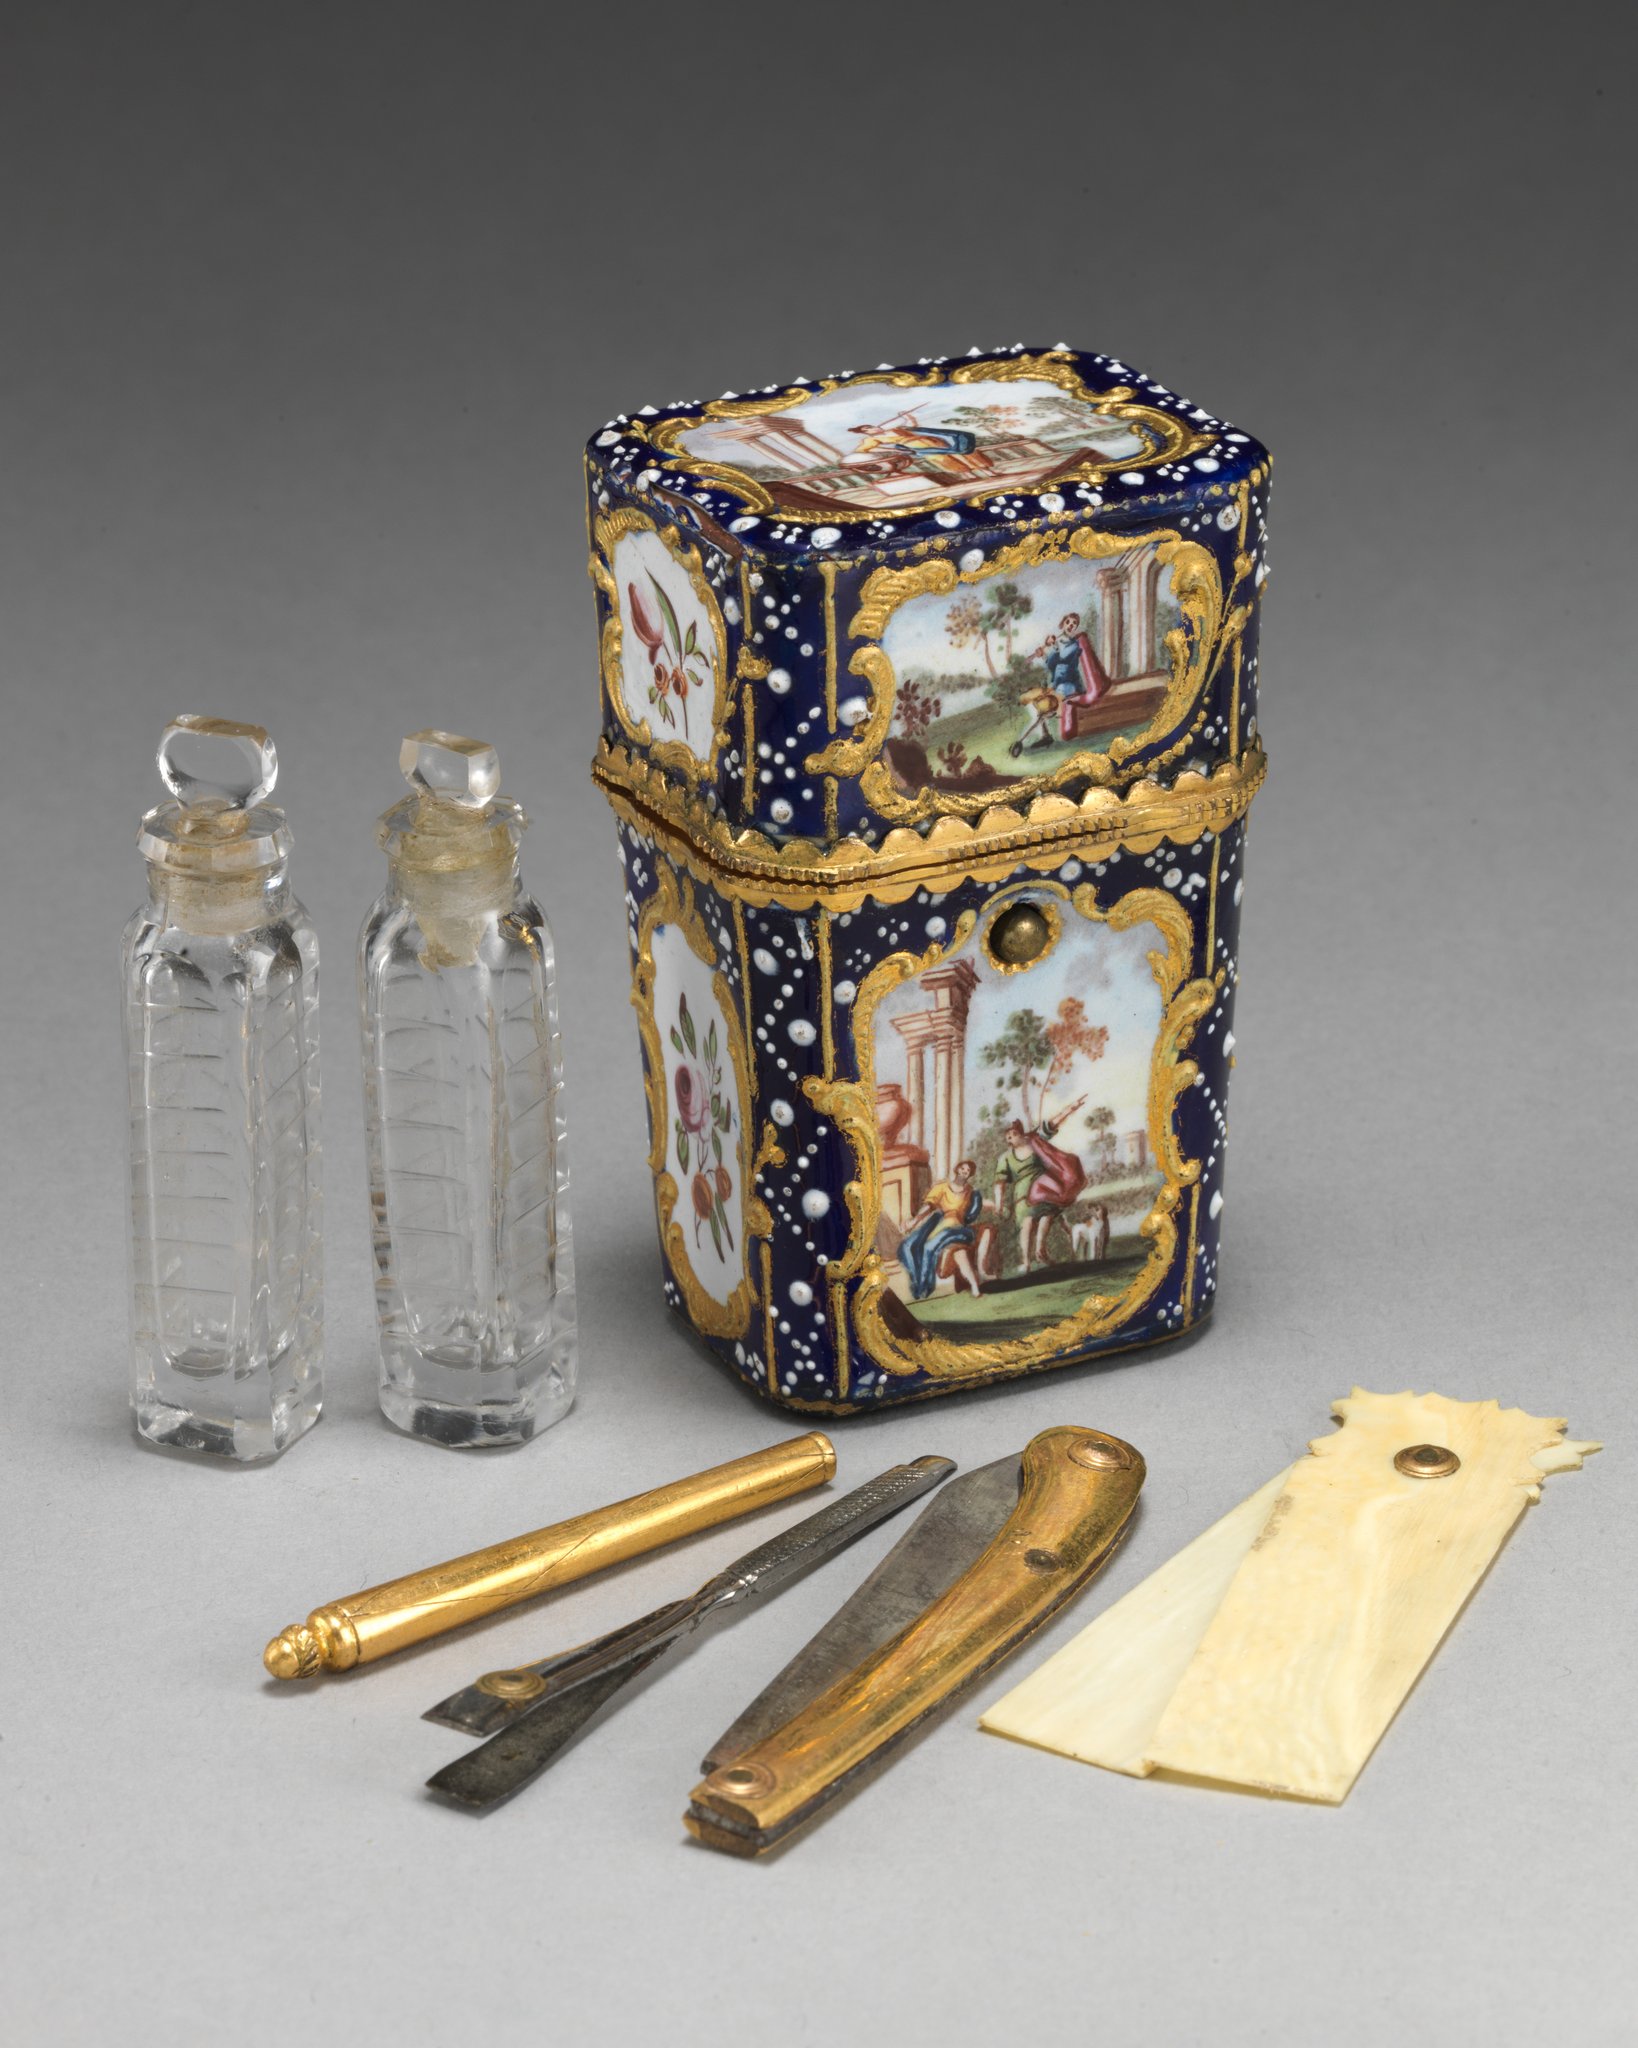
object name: nécessaire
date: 1765-1770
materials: copper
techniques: enamel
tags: human figures,animals,trees